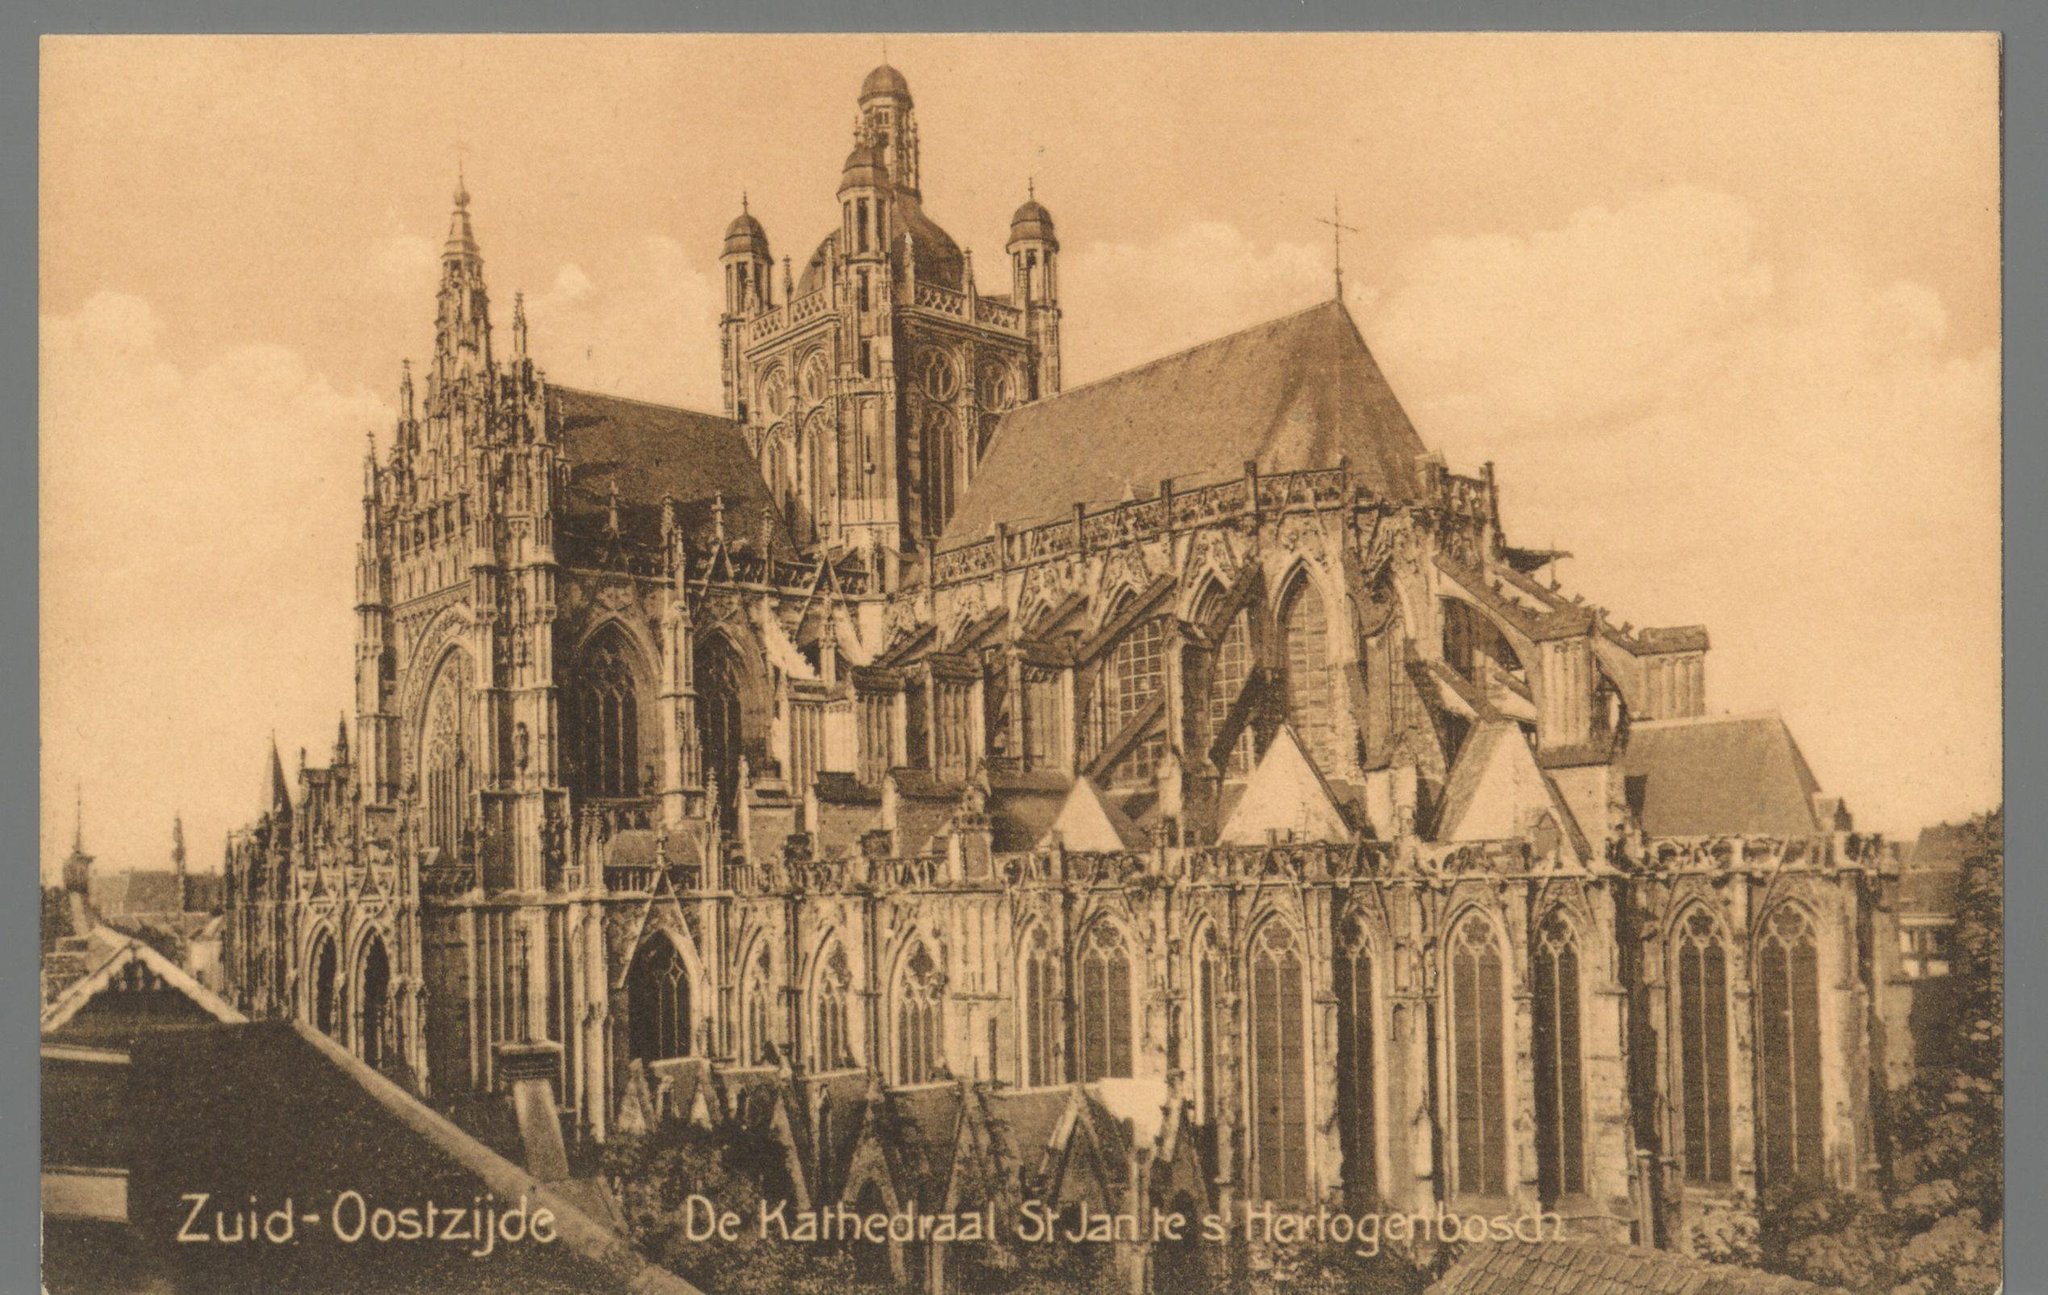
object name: ansichtkaart, prentbriefkaart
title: De Kathedraal St Jan te s' Hertogenbosch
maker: Anonymous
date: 1905-1930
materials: cardboard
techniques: photograph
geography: den bosch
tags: church (exterior)